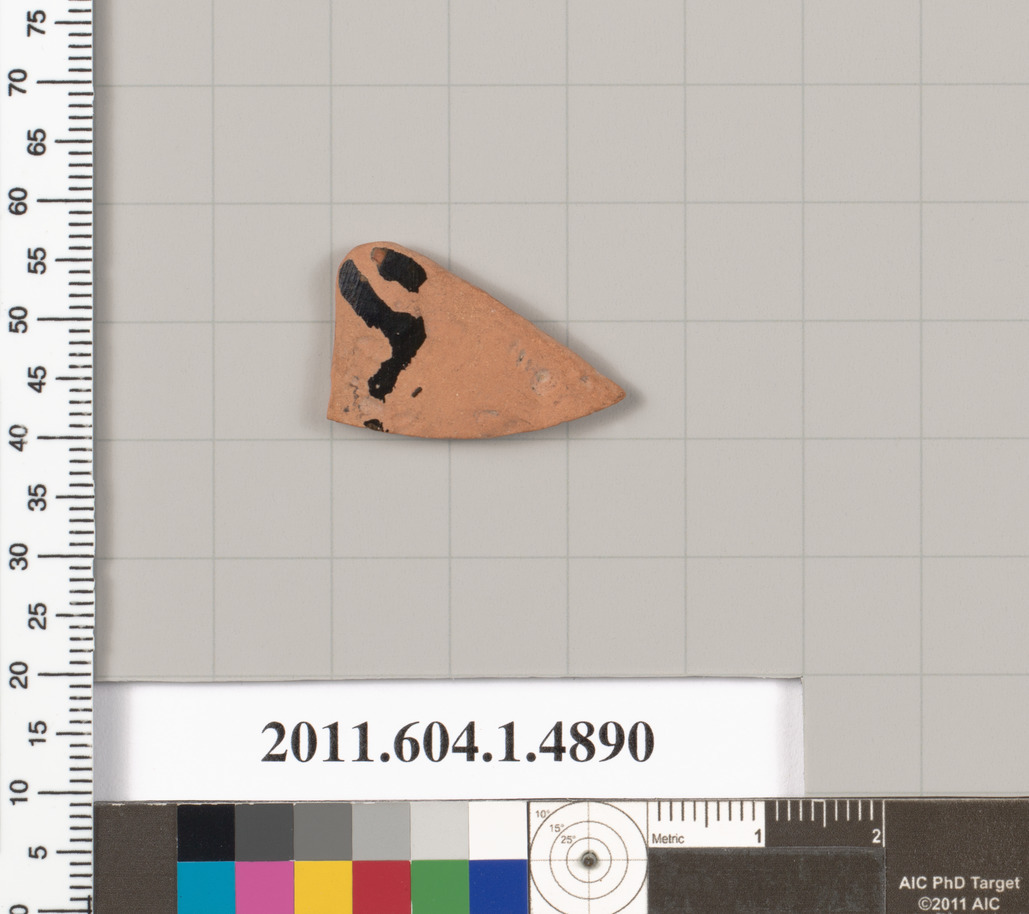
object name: kylix fragment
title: Terracotta fragment of a kylix (drinking cup)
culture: greek, attic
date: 475-451 BCE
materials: terracotta